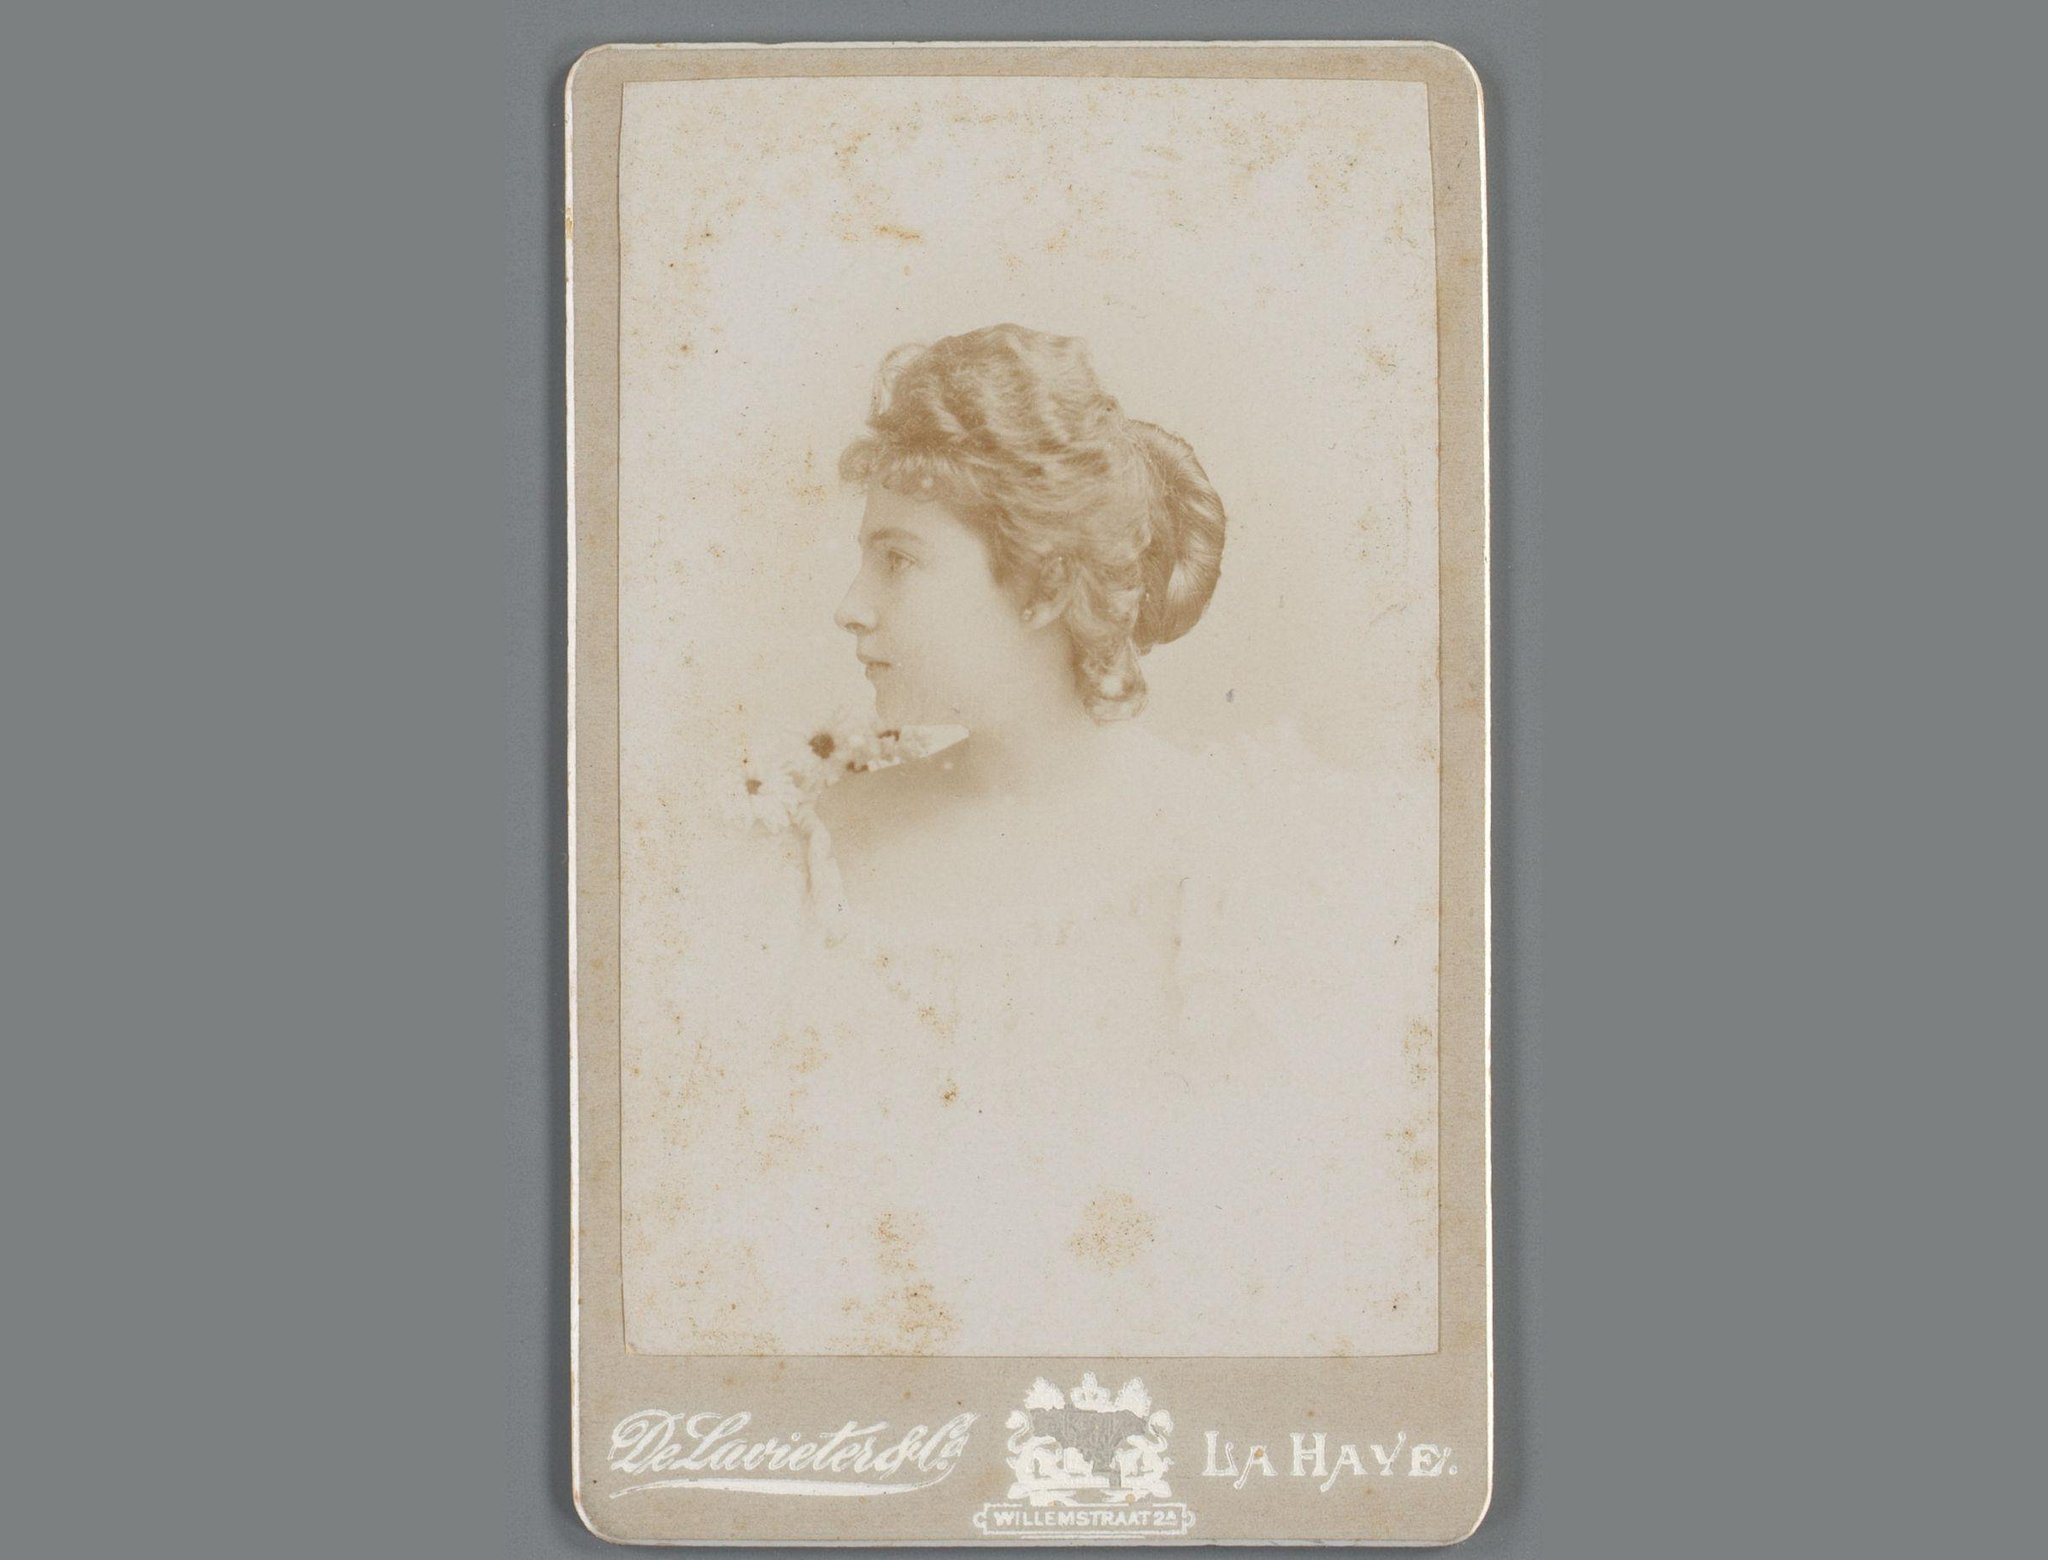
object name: photograph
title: Portret van een onbekende vrouw, mogelijk een lid van de familie Onnen-van den Berg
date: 1865-1903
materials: paper, cardboard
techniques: collodion silver print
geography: the hague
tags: anonymous historical person portrayed - bb - woman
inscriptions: address: ‘La Haye/ WILLEMSTRAAT 2a’